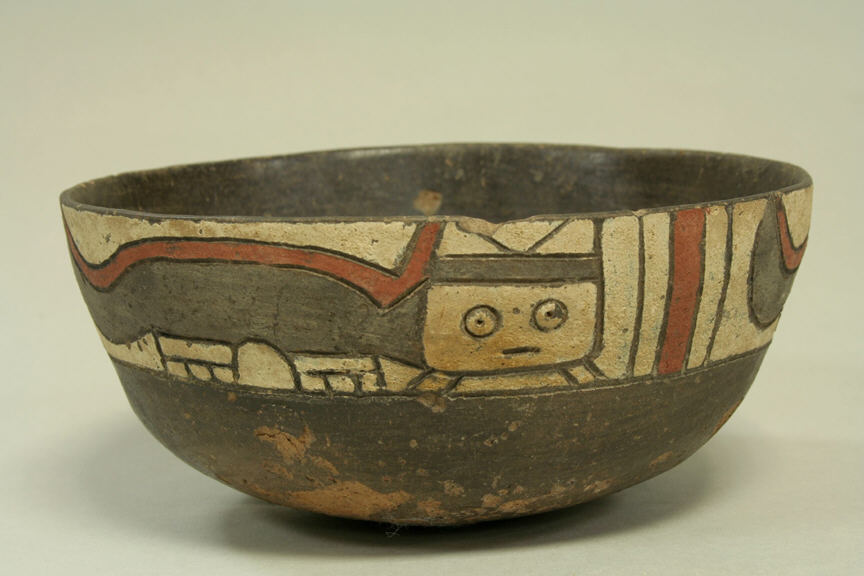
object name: bowl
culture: paracas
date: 600-301 BCE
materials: ceramic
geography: peru